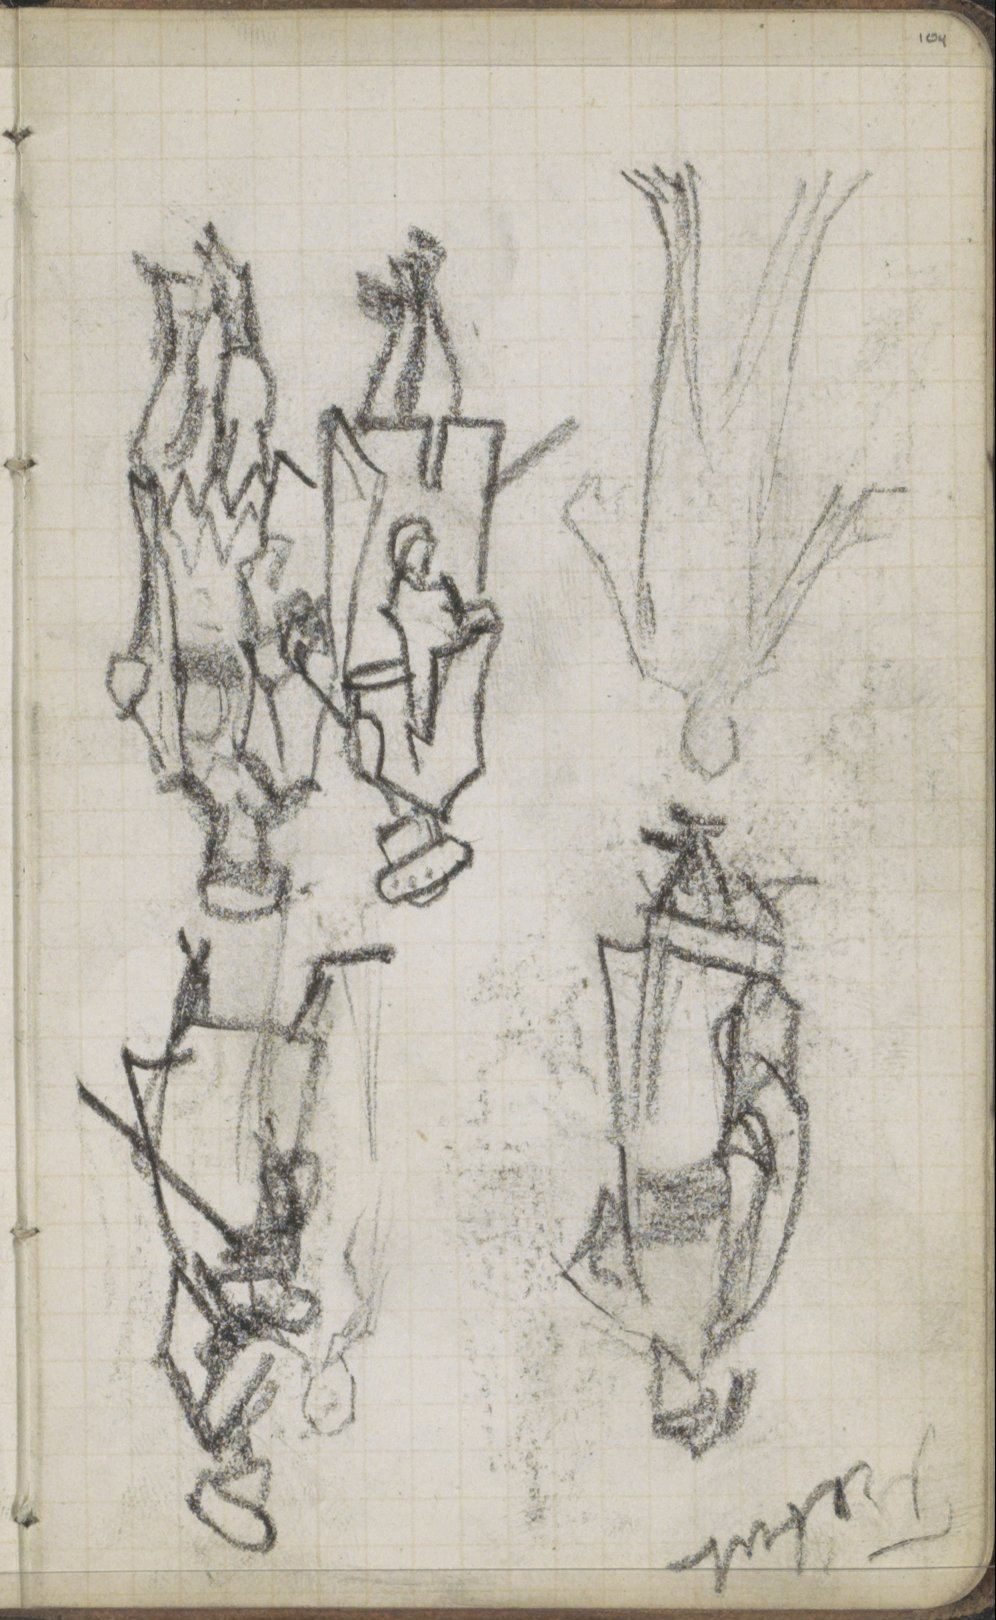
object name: sketchbook leaf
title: Mannen in historisch kostuum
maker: marius bauer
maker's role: draughtsman, print maker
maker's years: 1867-1932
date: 1879-1885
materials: chalk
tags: standing figure, adult man, hacking and thrusting weapons: sword, historical costume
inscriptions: annotation: ‘Tribut’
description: Mogelijk kostuums voor een theaterstuk. Pagina 104 uit een schetsboek met 58 bladen.